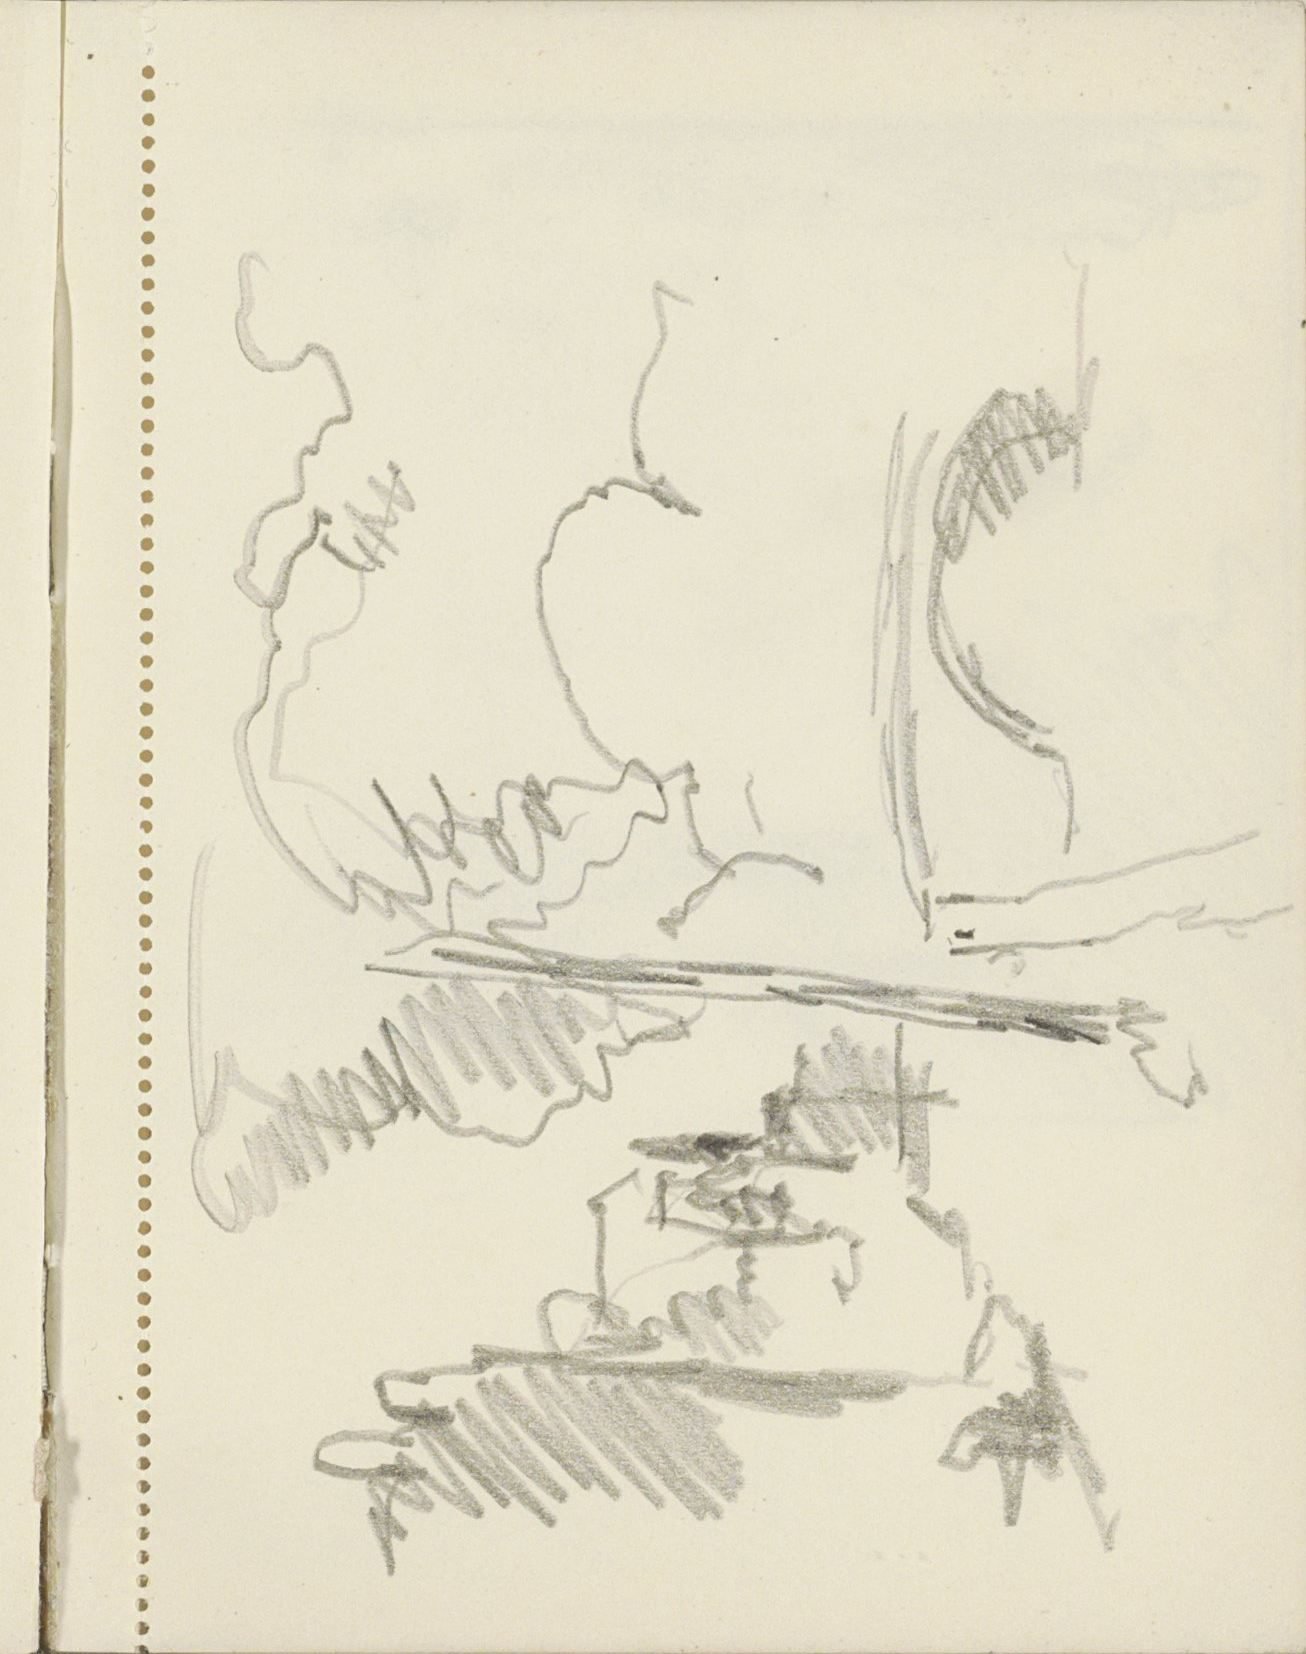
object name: sketchbook leaf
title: Straat langs een gracht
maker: cornelis vreedenburgh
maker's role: draughtsman, print maker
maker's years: 1880-1946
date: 1890-1946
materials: paper, pencil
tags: bridge in city across river, canal, etc., street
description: Over de gracht een brug. Blad 25 recto uit een schetsboek met 71 bladen.